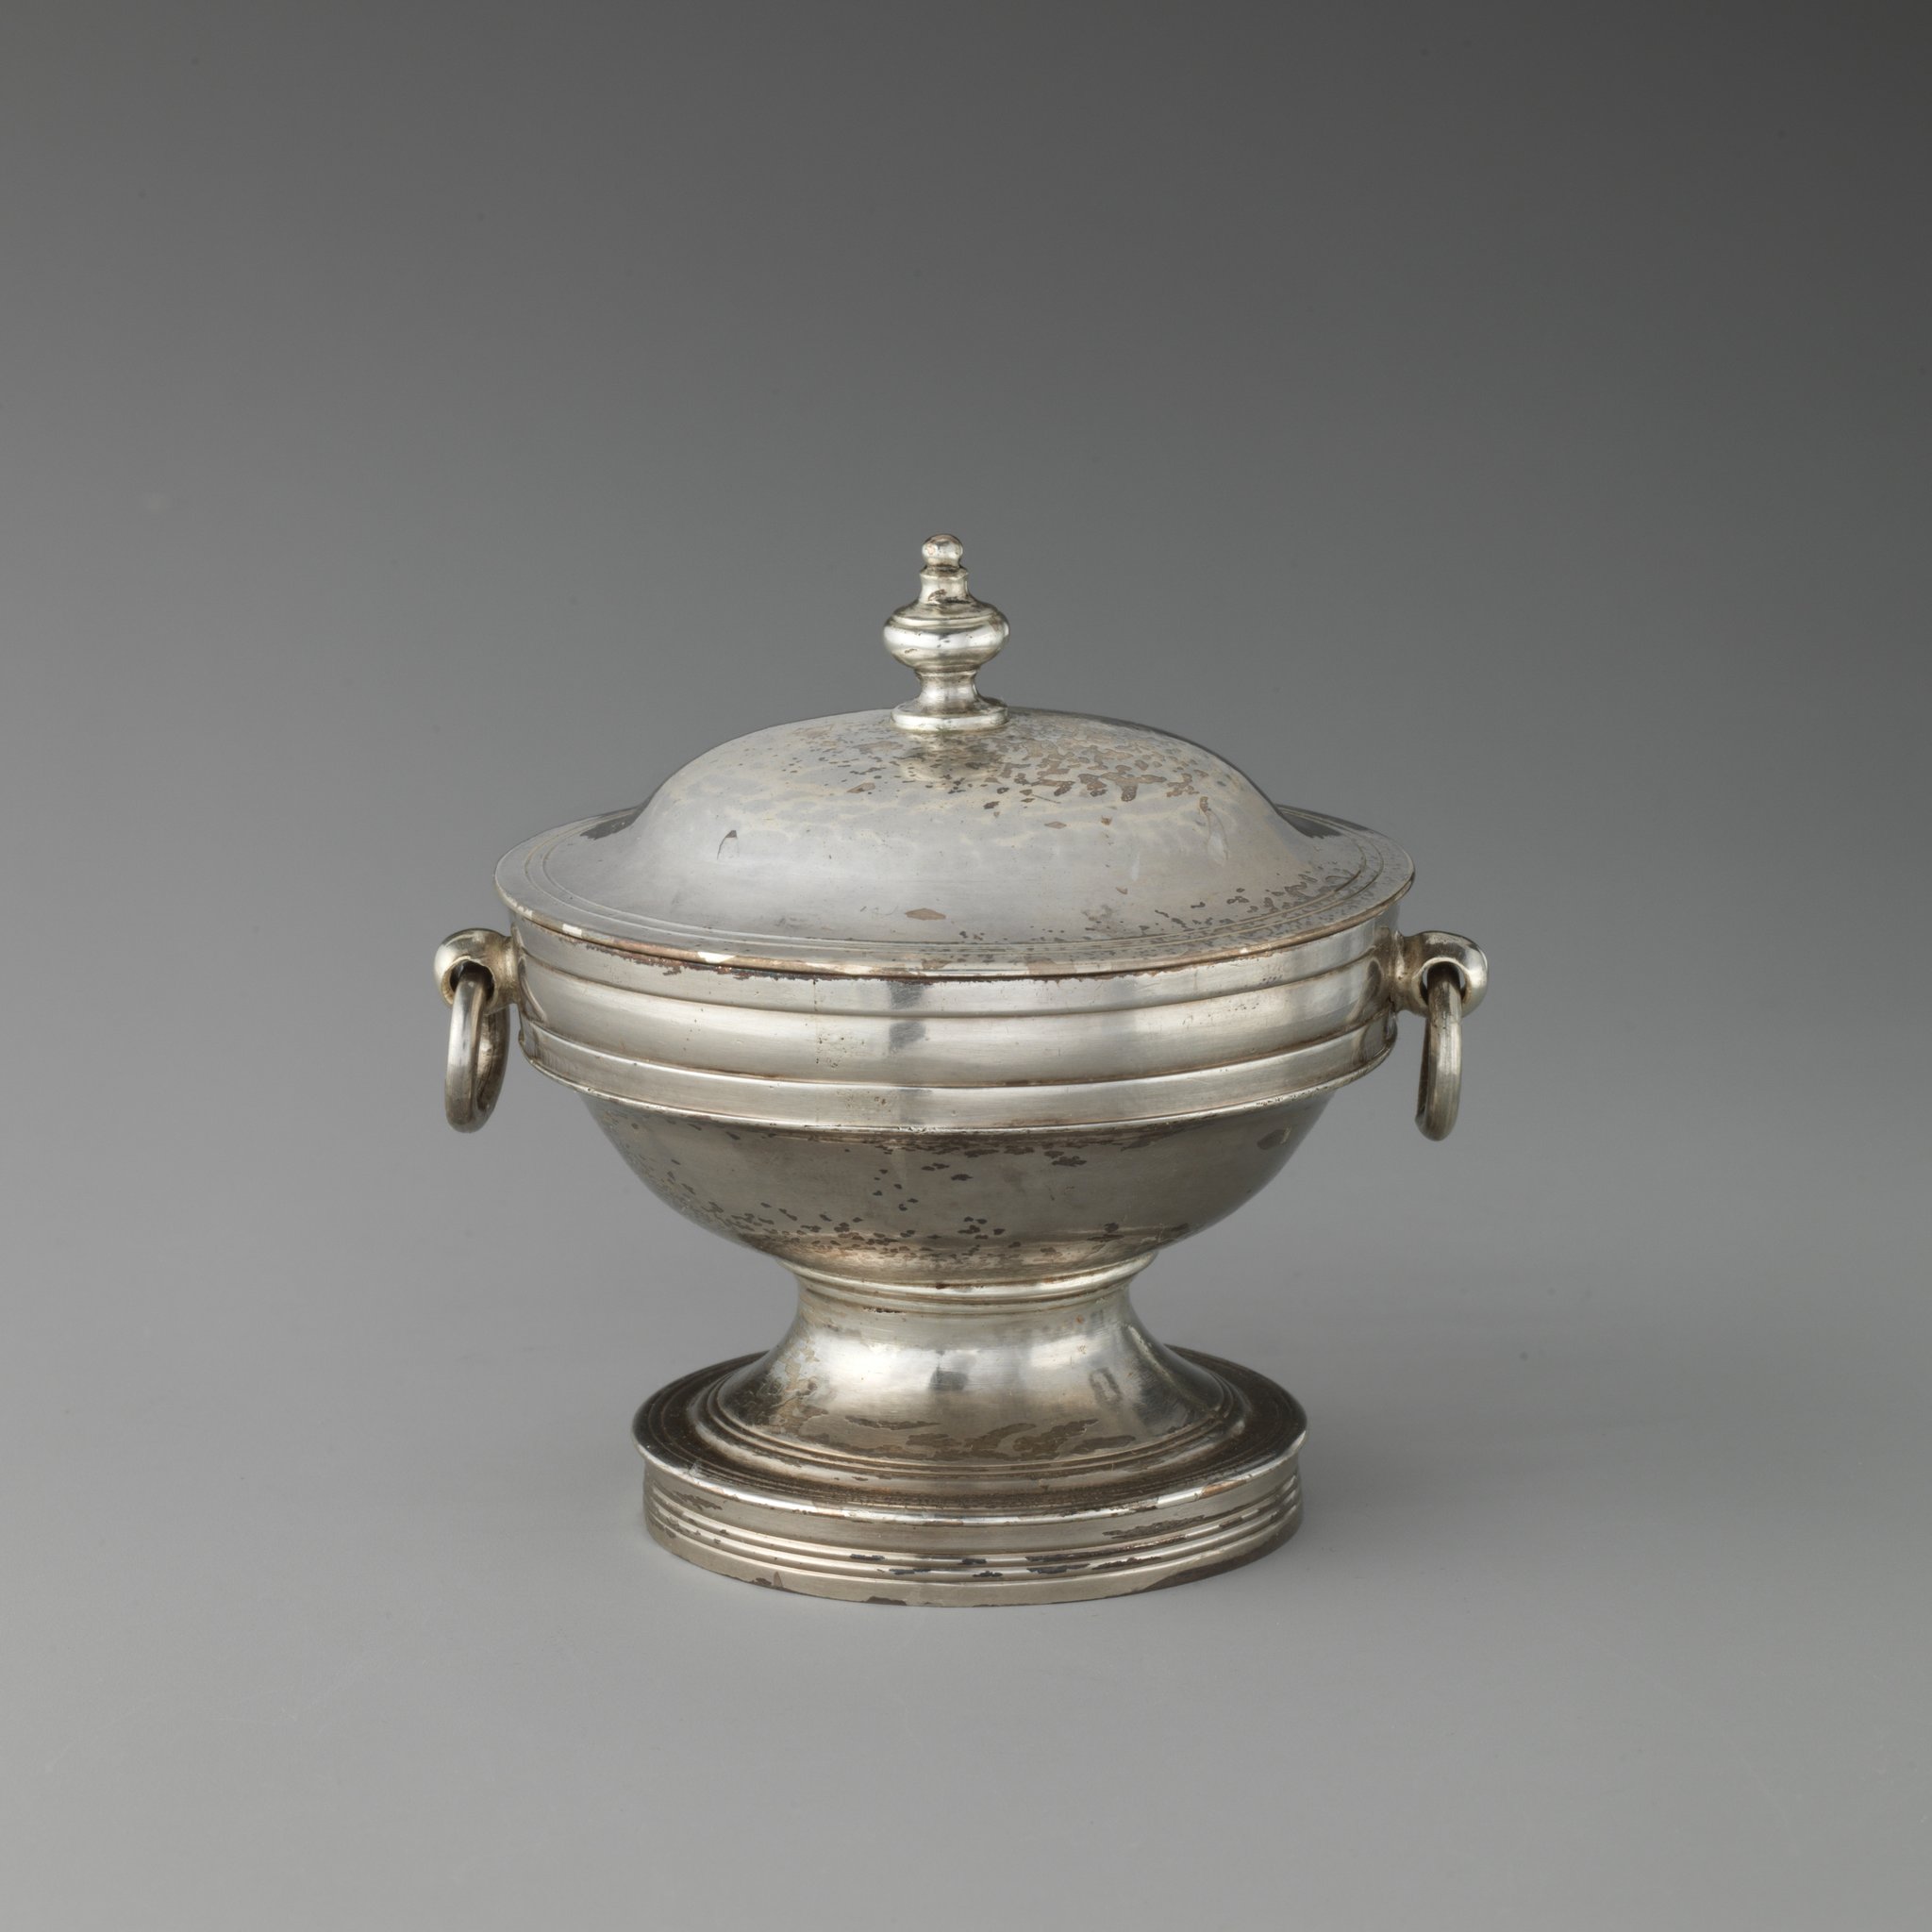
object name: tureen with cover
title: Miniature tureen with cover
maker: thomas howell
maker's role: maker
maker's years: 1791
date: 1790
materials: silver